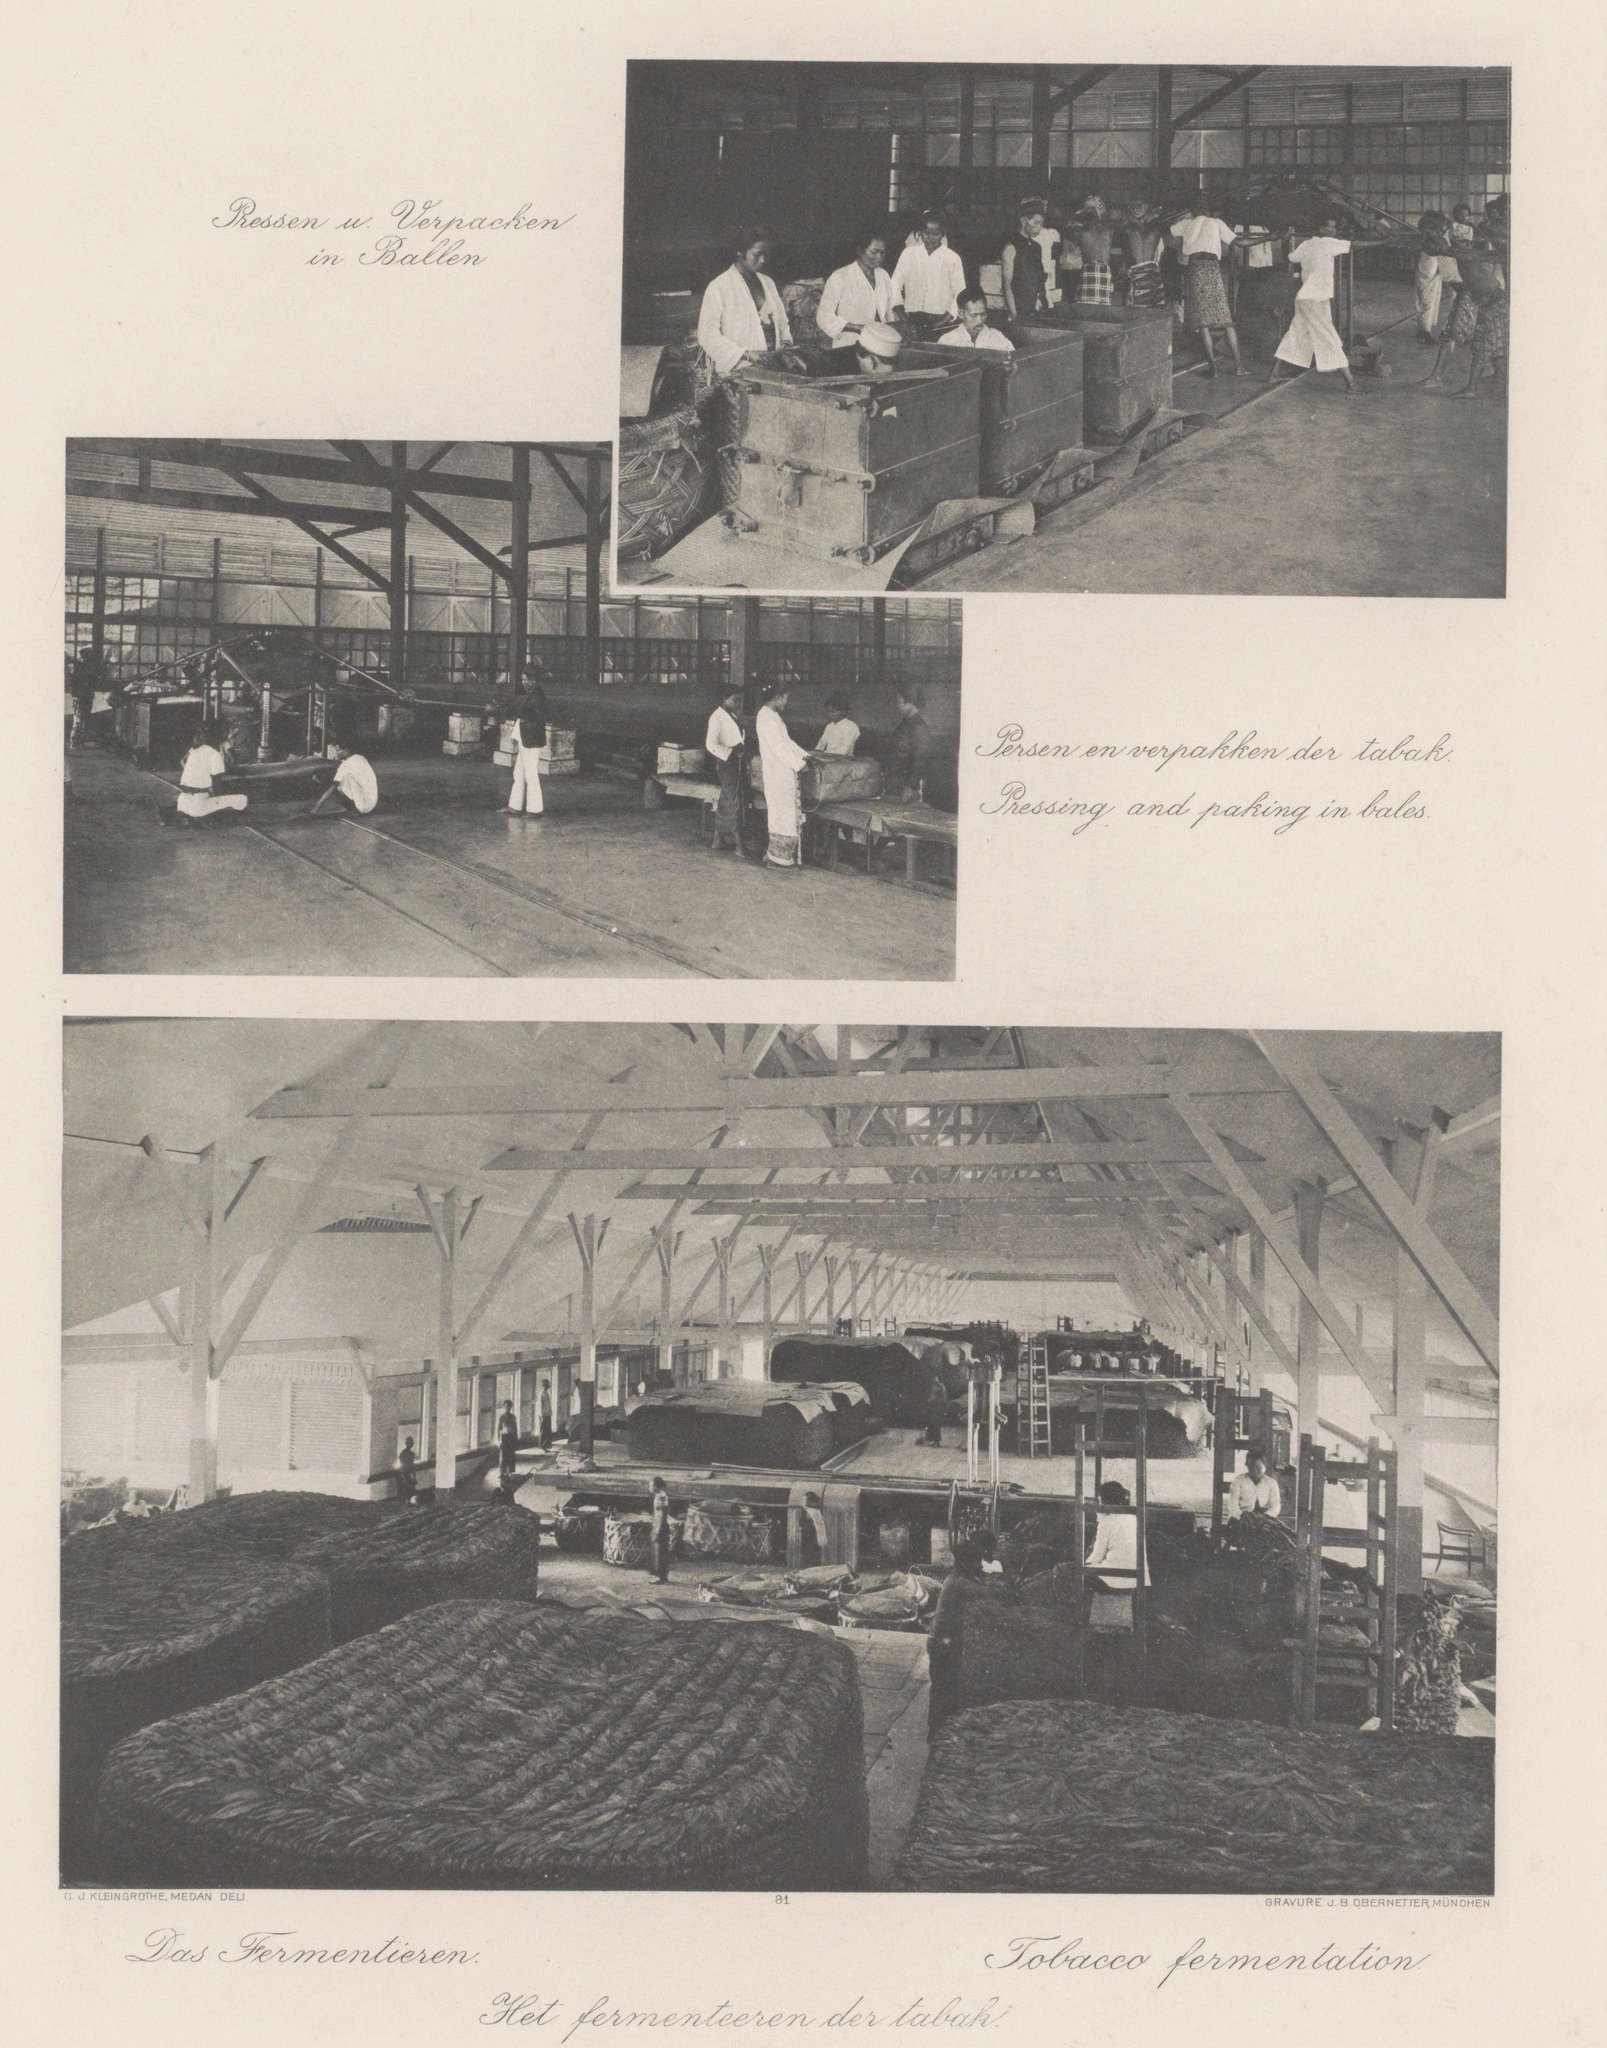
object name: photomechanical print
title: Werkzaamheden in een tabaksschuur op Sumatra: persen en verpakken (boven en midden), fermenteren (onder)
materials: paper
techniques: photoaquatint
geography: munich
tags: plantation, barn, tobacco, sumatra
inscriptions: number: ‘31’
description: Onderdeel van Album met heliogravures van Sumatra's oostkust.